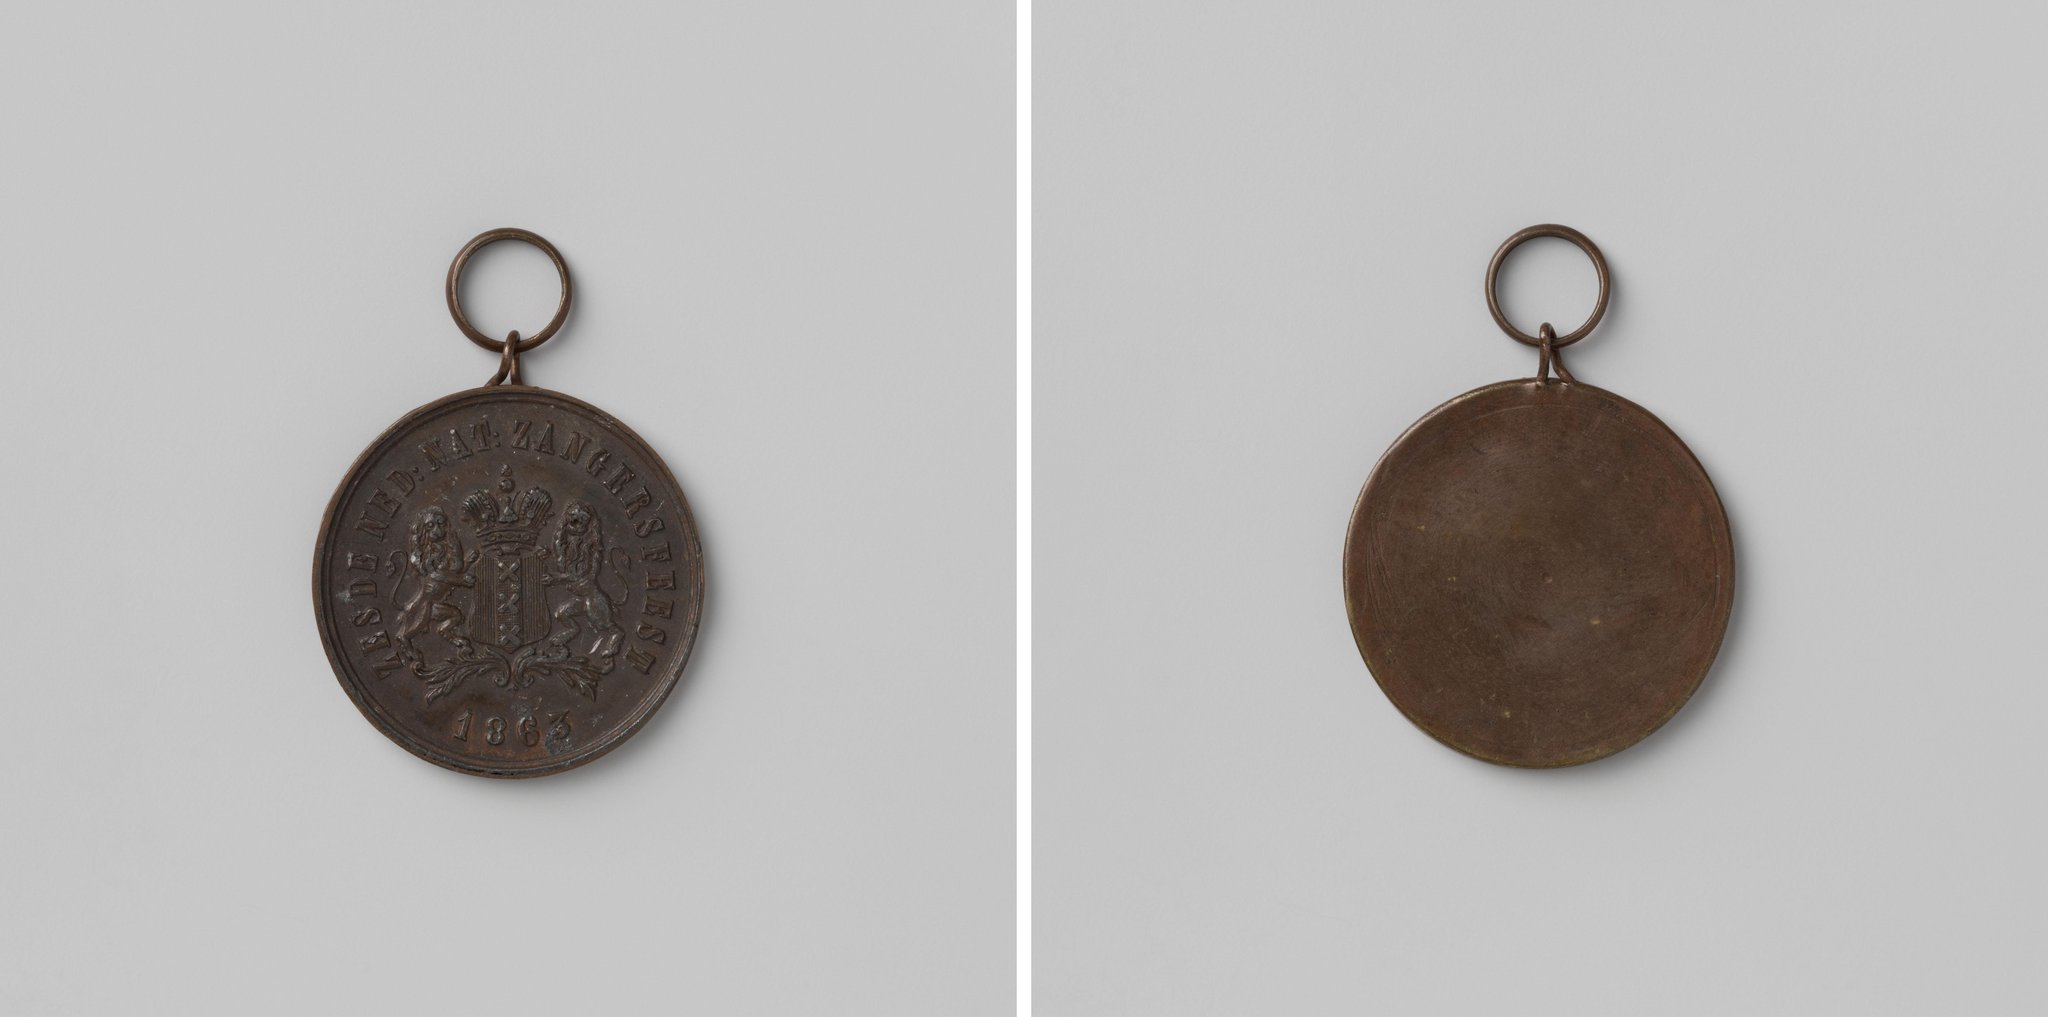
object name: insignia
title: Zesde Nederlandsch nationaal zangersfeest te Amsterdam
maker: Anonymous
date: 1863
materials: bronze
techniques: striking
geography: amsterdam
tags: amsterdam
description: Eenzijdige bronzen insigne aan draagoog en draagring. Voorzijde: gekroond wapenschild geflankeerd door twee leeuwen binnen omschrift. Keerzijde: blanco.